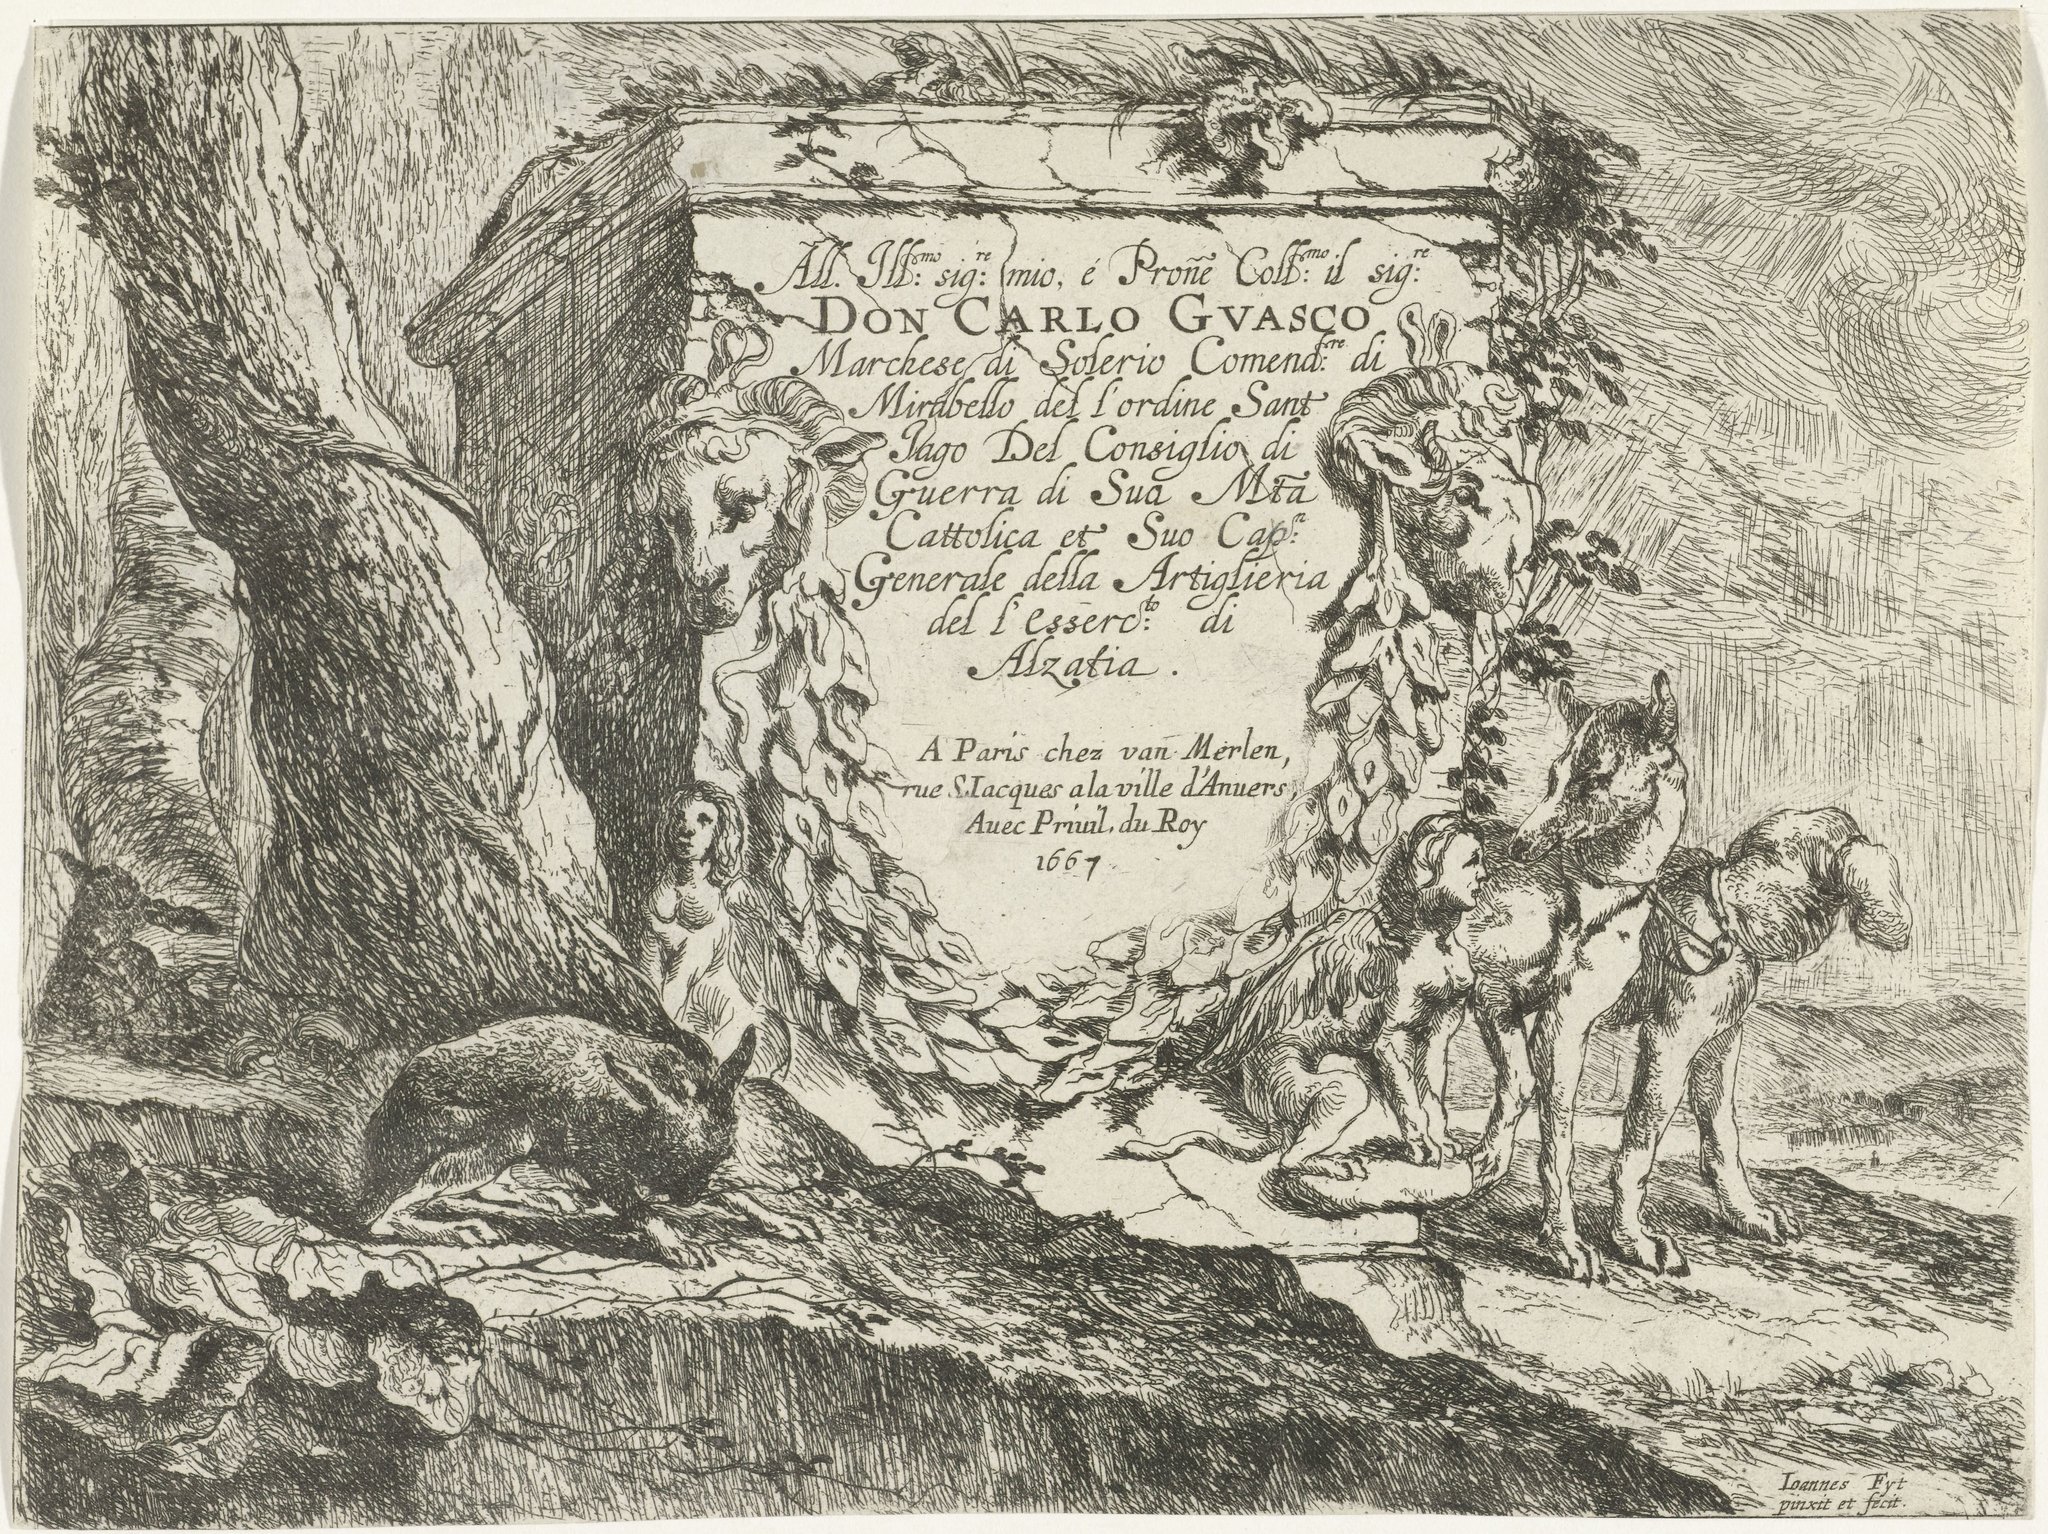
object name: titelprent, frontispice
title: Titelprent voor serie honden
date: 1667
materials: paper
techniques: etching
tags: dog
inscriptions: collector's mark: Lugt 2228